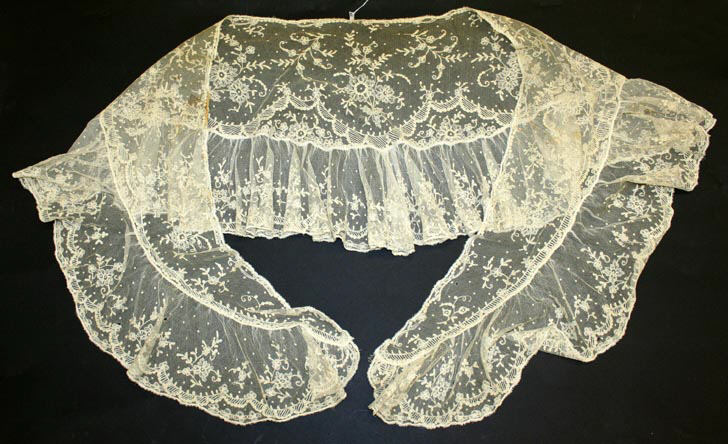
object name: fichu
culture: european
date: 1801-1900